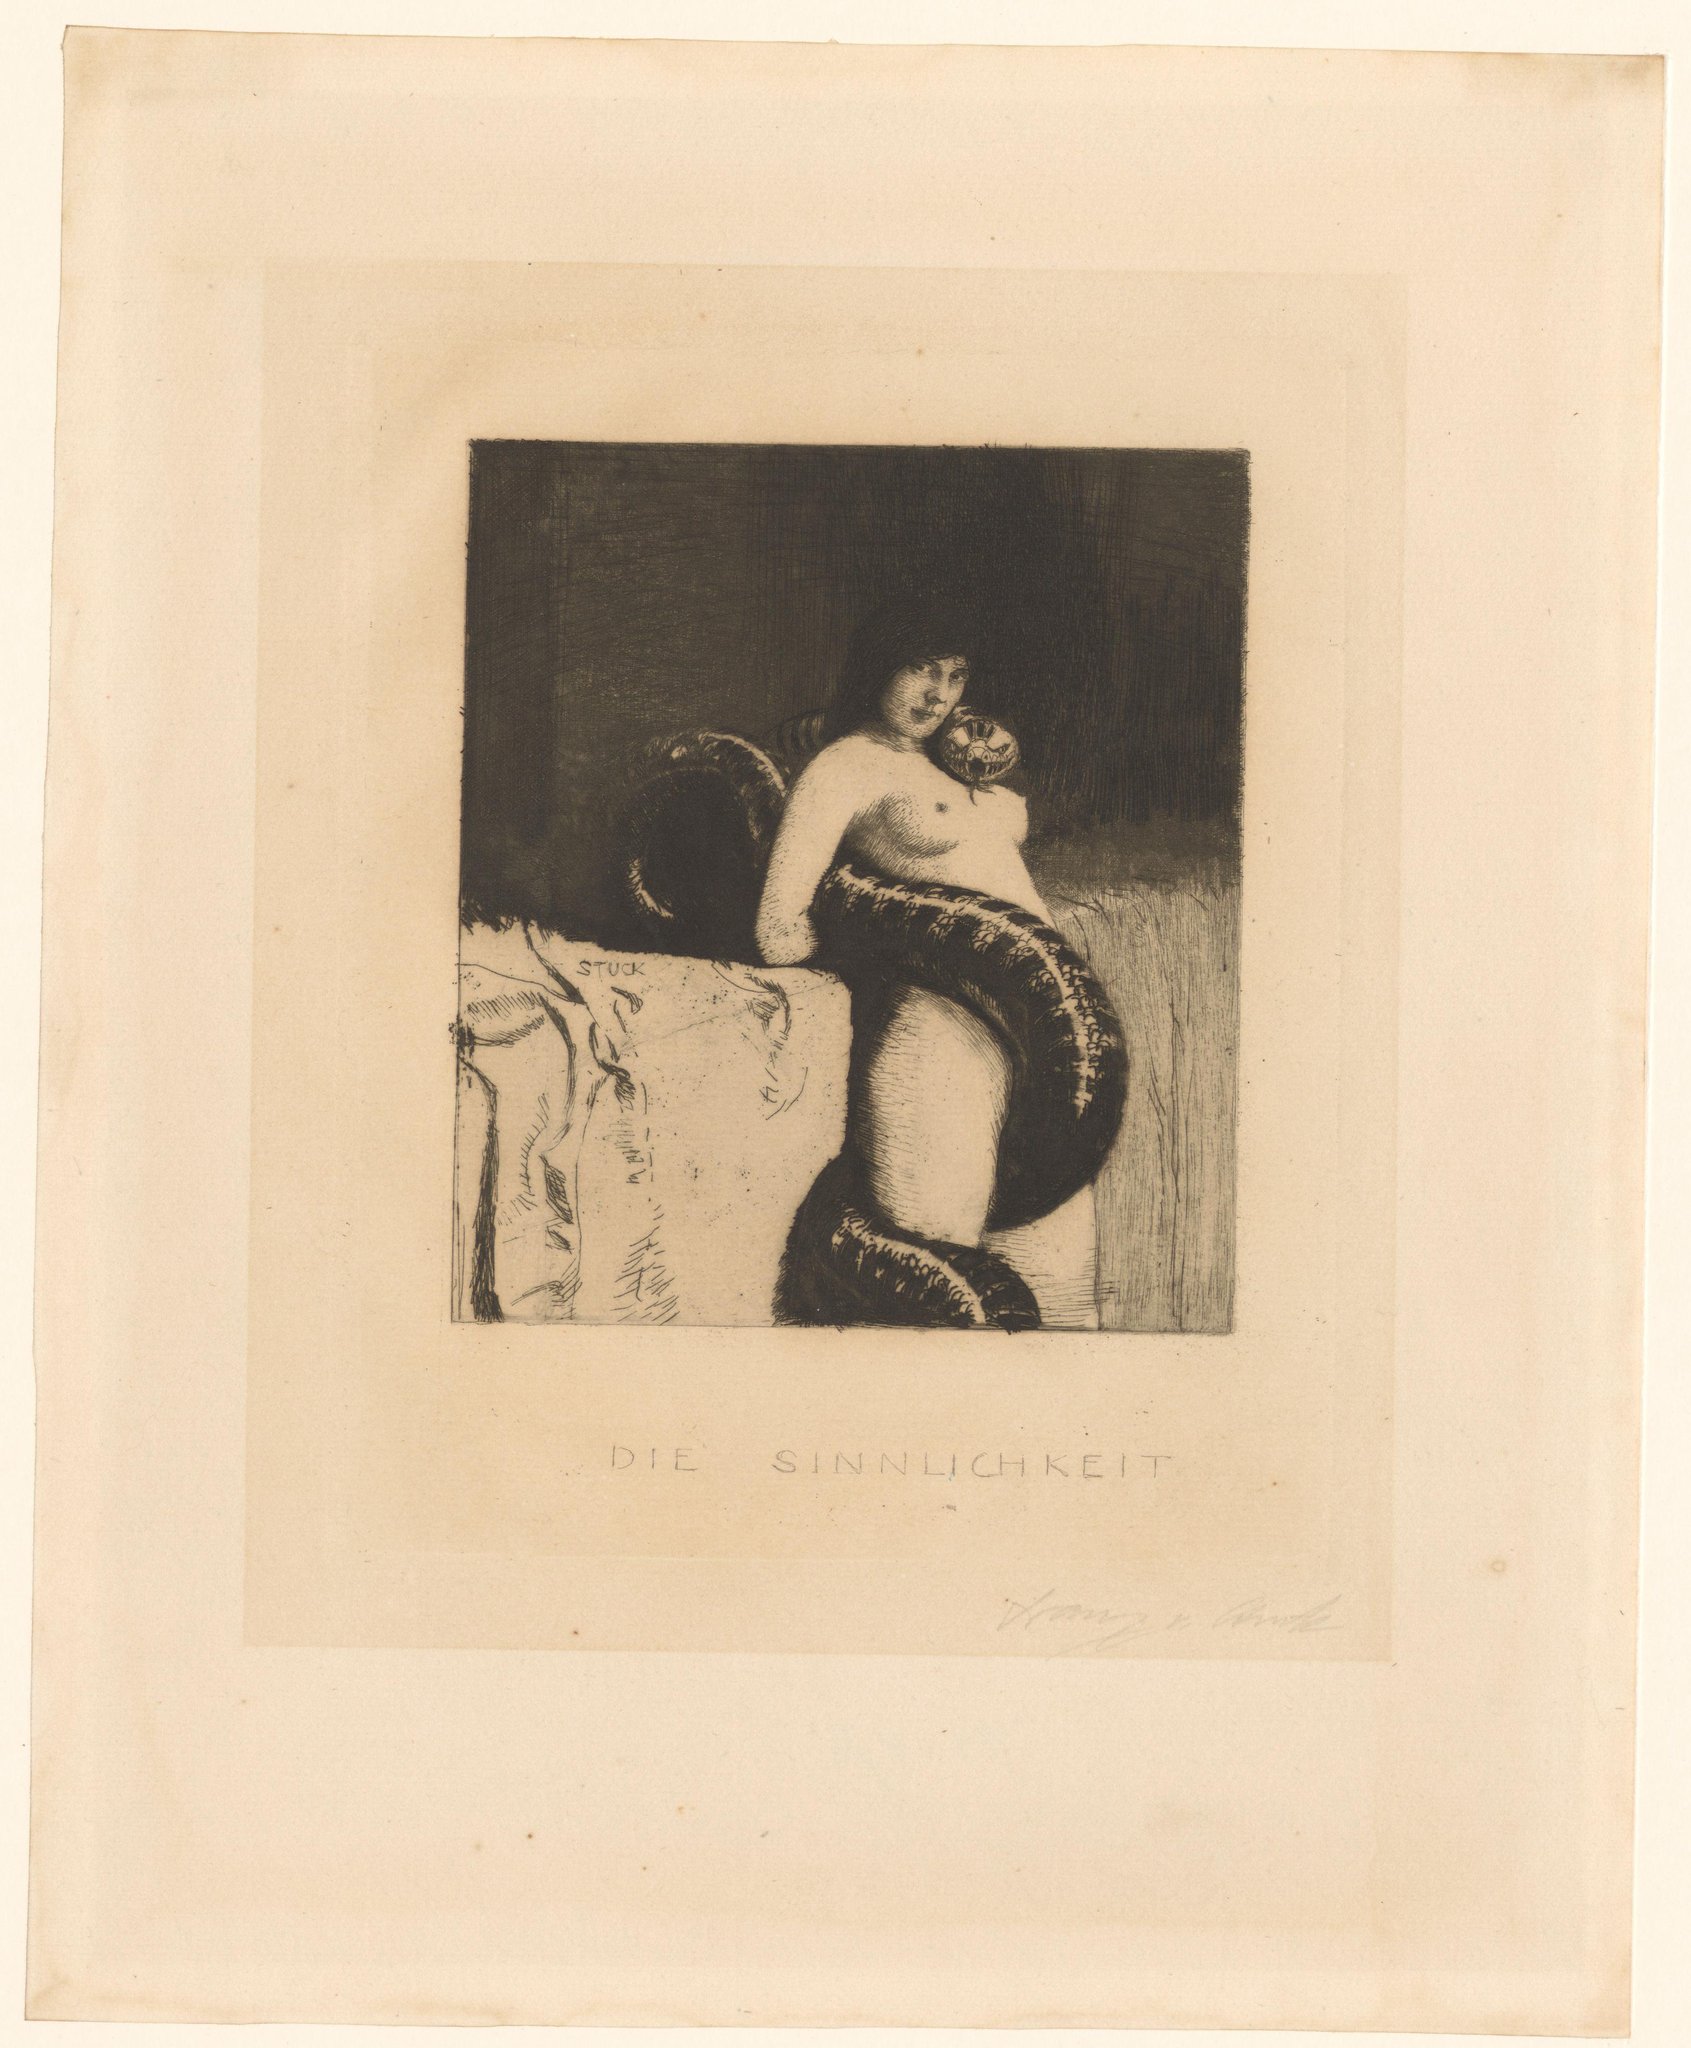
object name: print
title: Die Sinnlichkeit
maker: franz von stuck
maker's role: draughtsman, painter, print maker, sculptor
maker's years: 1862-1928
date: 1889-1891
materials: paper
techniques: etching, intaglio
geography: germany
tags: snakes, sensuality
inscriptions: collector's mark: Lugt 2228